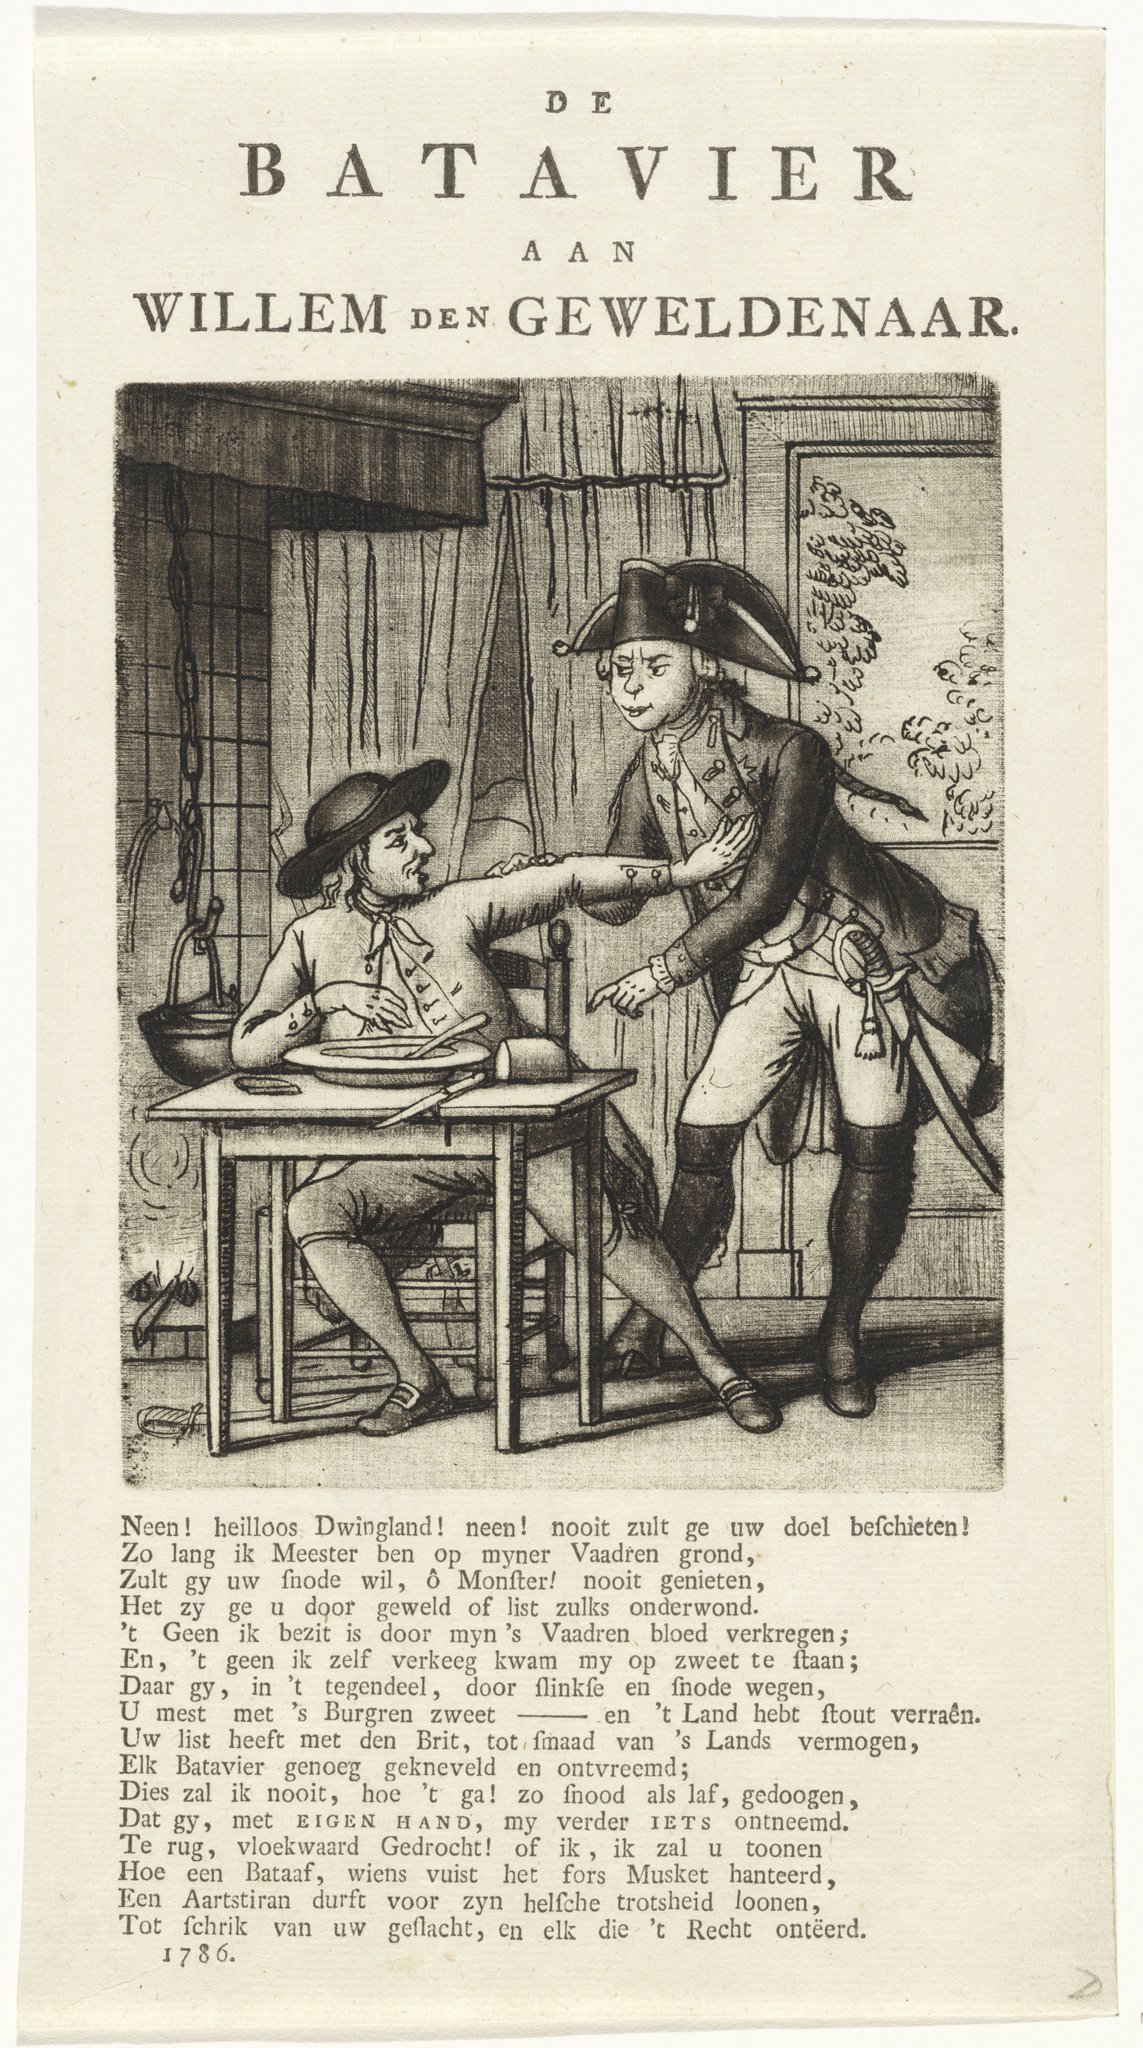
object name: print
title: Spotprent op Willem V die een Gelderse boer zijn eten wil afnemen, 1786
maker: johannes jelgerhuis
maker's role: draughtsman, painter, print maker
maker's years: 1770-1836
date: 1786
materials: paper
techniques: letterpress printing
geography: northern netherlands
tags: the hague, william v (prince of orange), eating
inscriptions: date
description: Spotprent op stadhouder Willem V na de gebeurtenissen rond Hattem en Elburg, begin september 1786. De prins wil het bord met eten en brood afpakken van een Gelderse boer, die hier fel tegen protesteert. Op het blad onder de plaat een vers van zestien regels: Neen! heilloos Dwingland! neen!